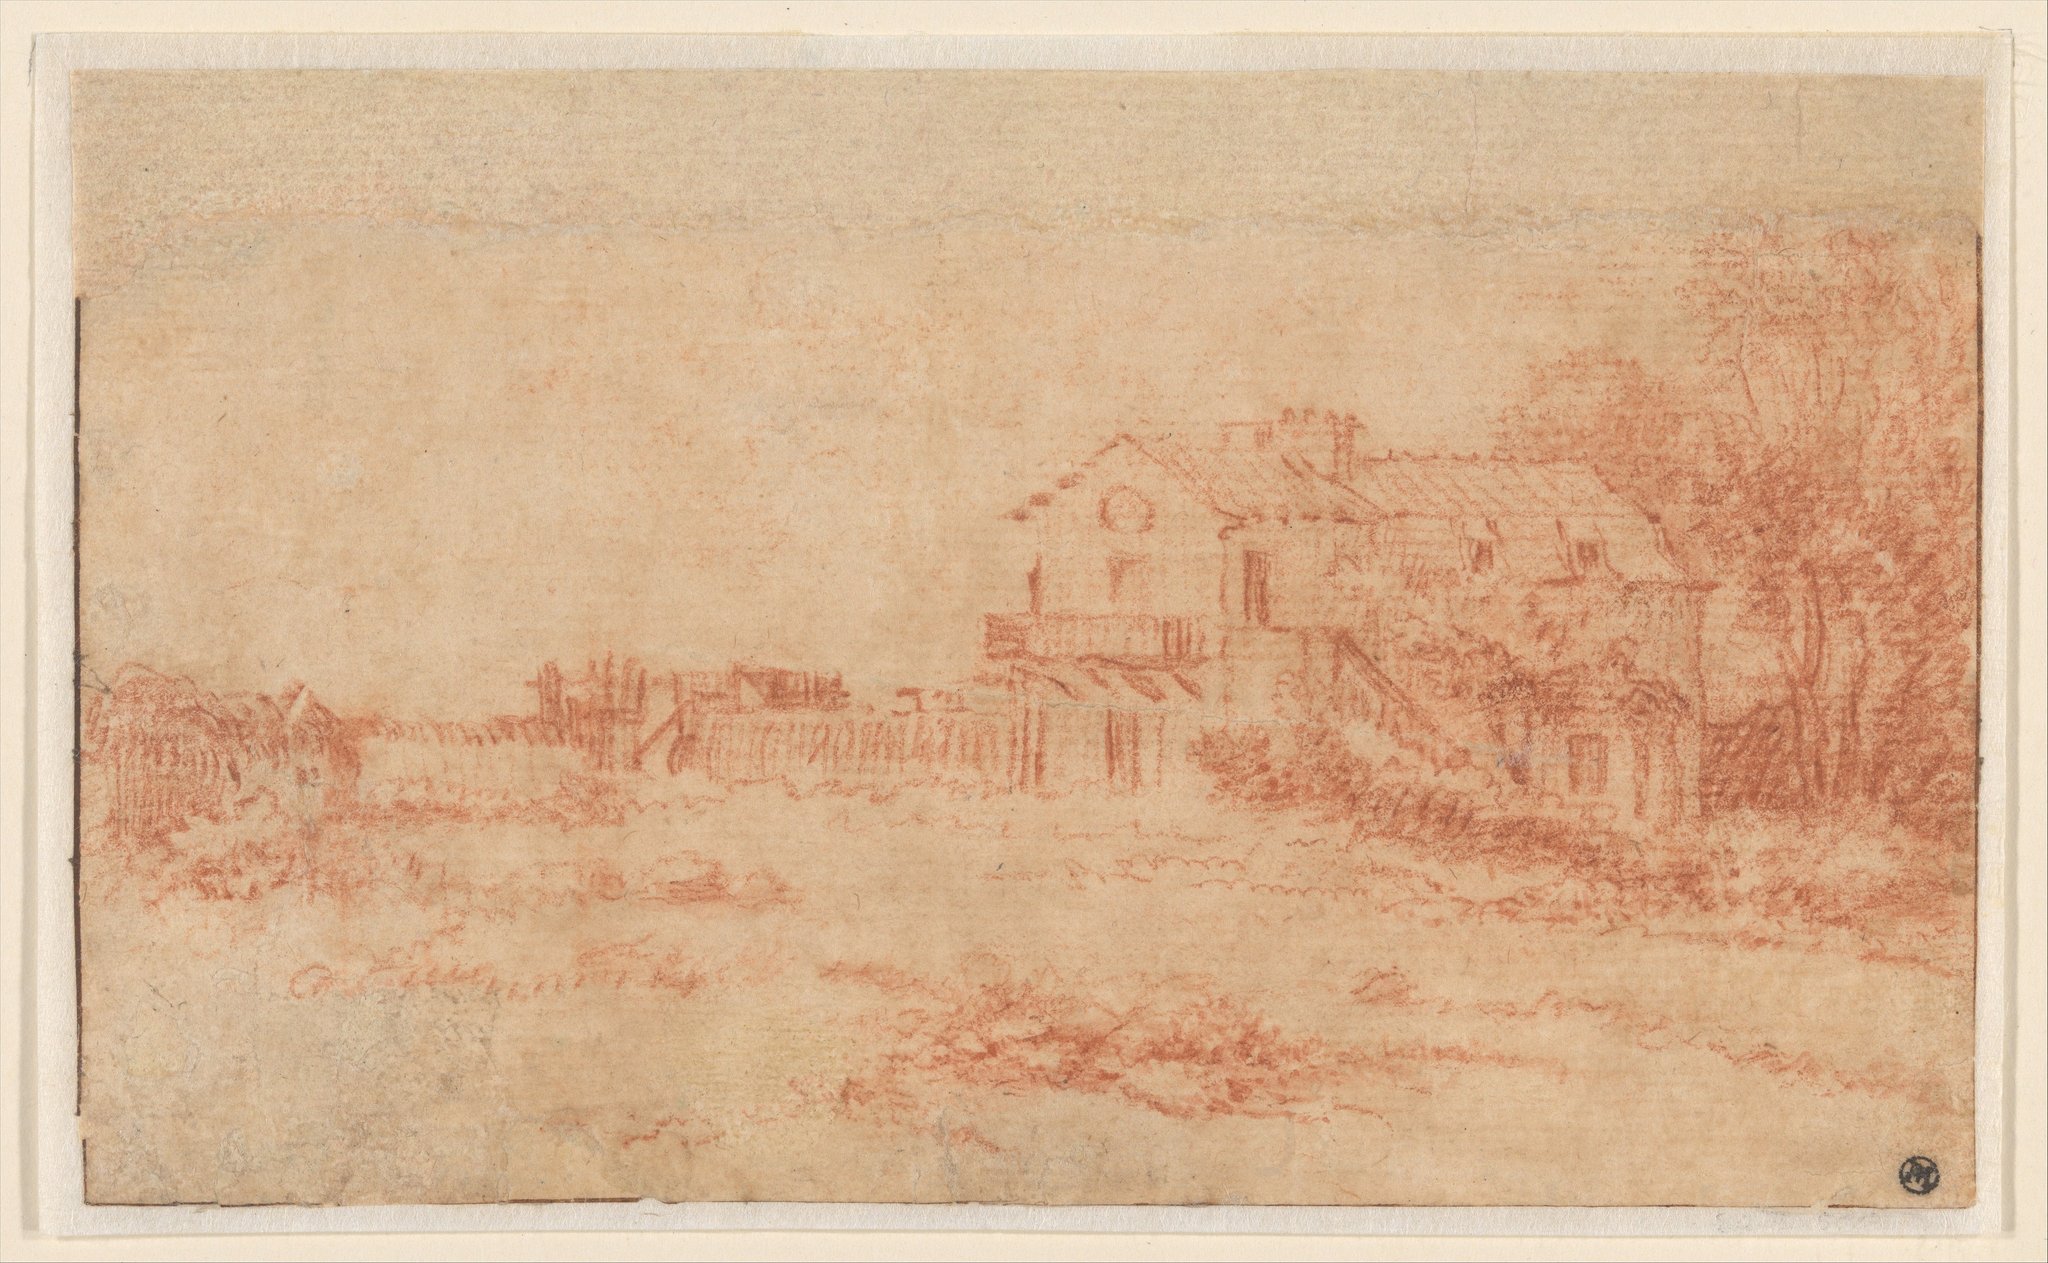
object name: drawing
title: Landscape with a Country House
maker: antoine watteau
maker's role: artist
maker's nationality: french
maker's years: 1684-1721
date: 1714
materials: chalk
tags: houses,landscapes,trees